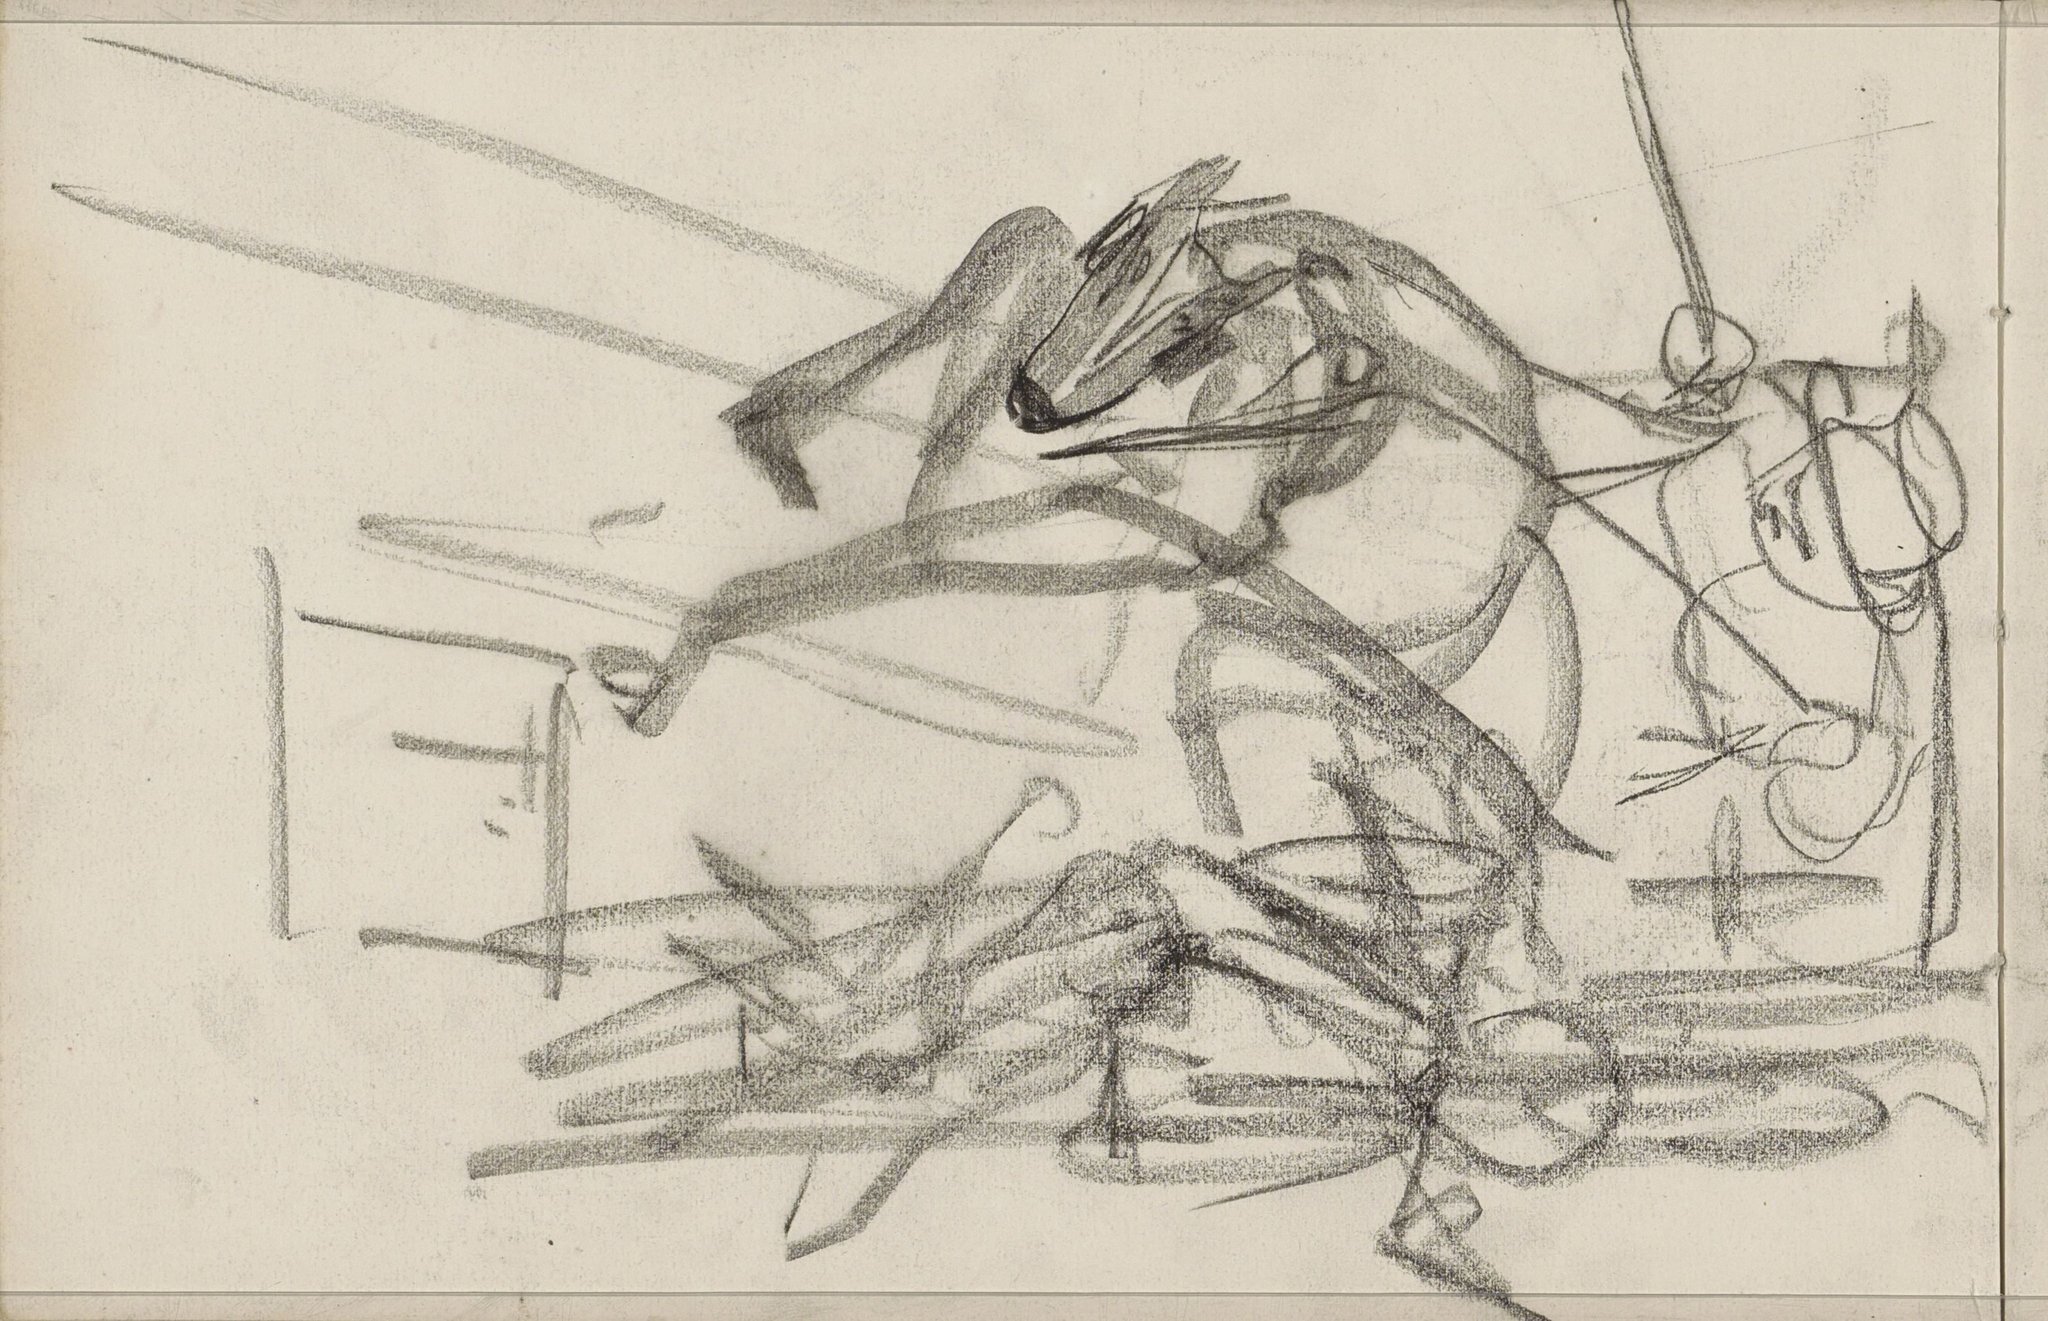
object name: sketchbook leaf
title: Galopperend paard voor een koets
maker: carel adolph lion cachet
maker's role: draughtsman, print maker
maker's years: 1864-1945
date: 1895-1900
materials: chalk, paper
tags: animal traction, animal-drawn vehicle (carriage etc.), galloping horse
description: Voorop de koets zit een man met een zweep. Blad 14 verso uit een schetsboek met 19 bladen.